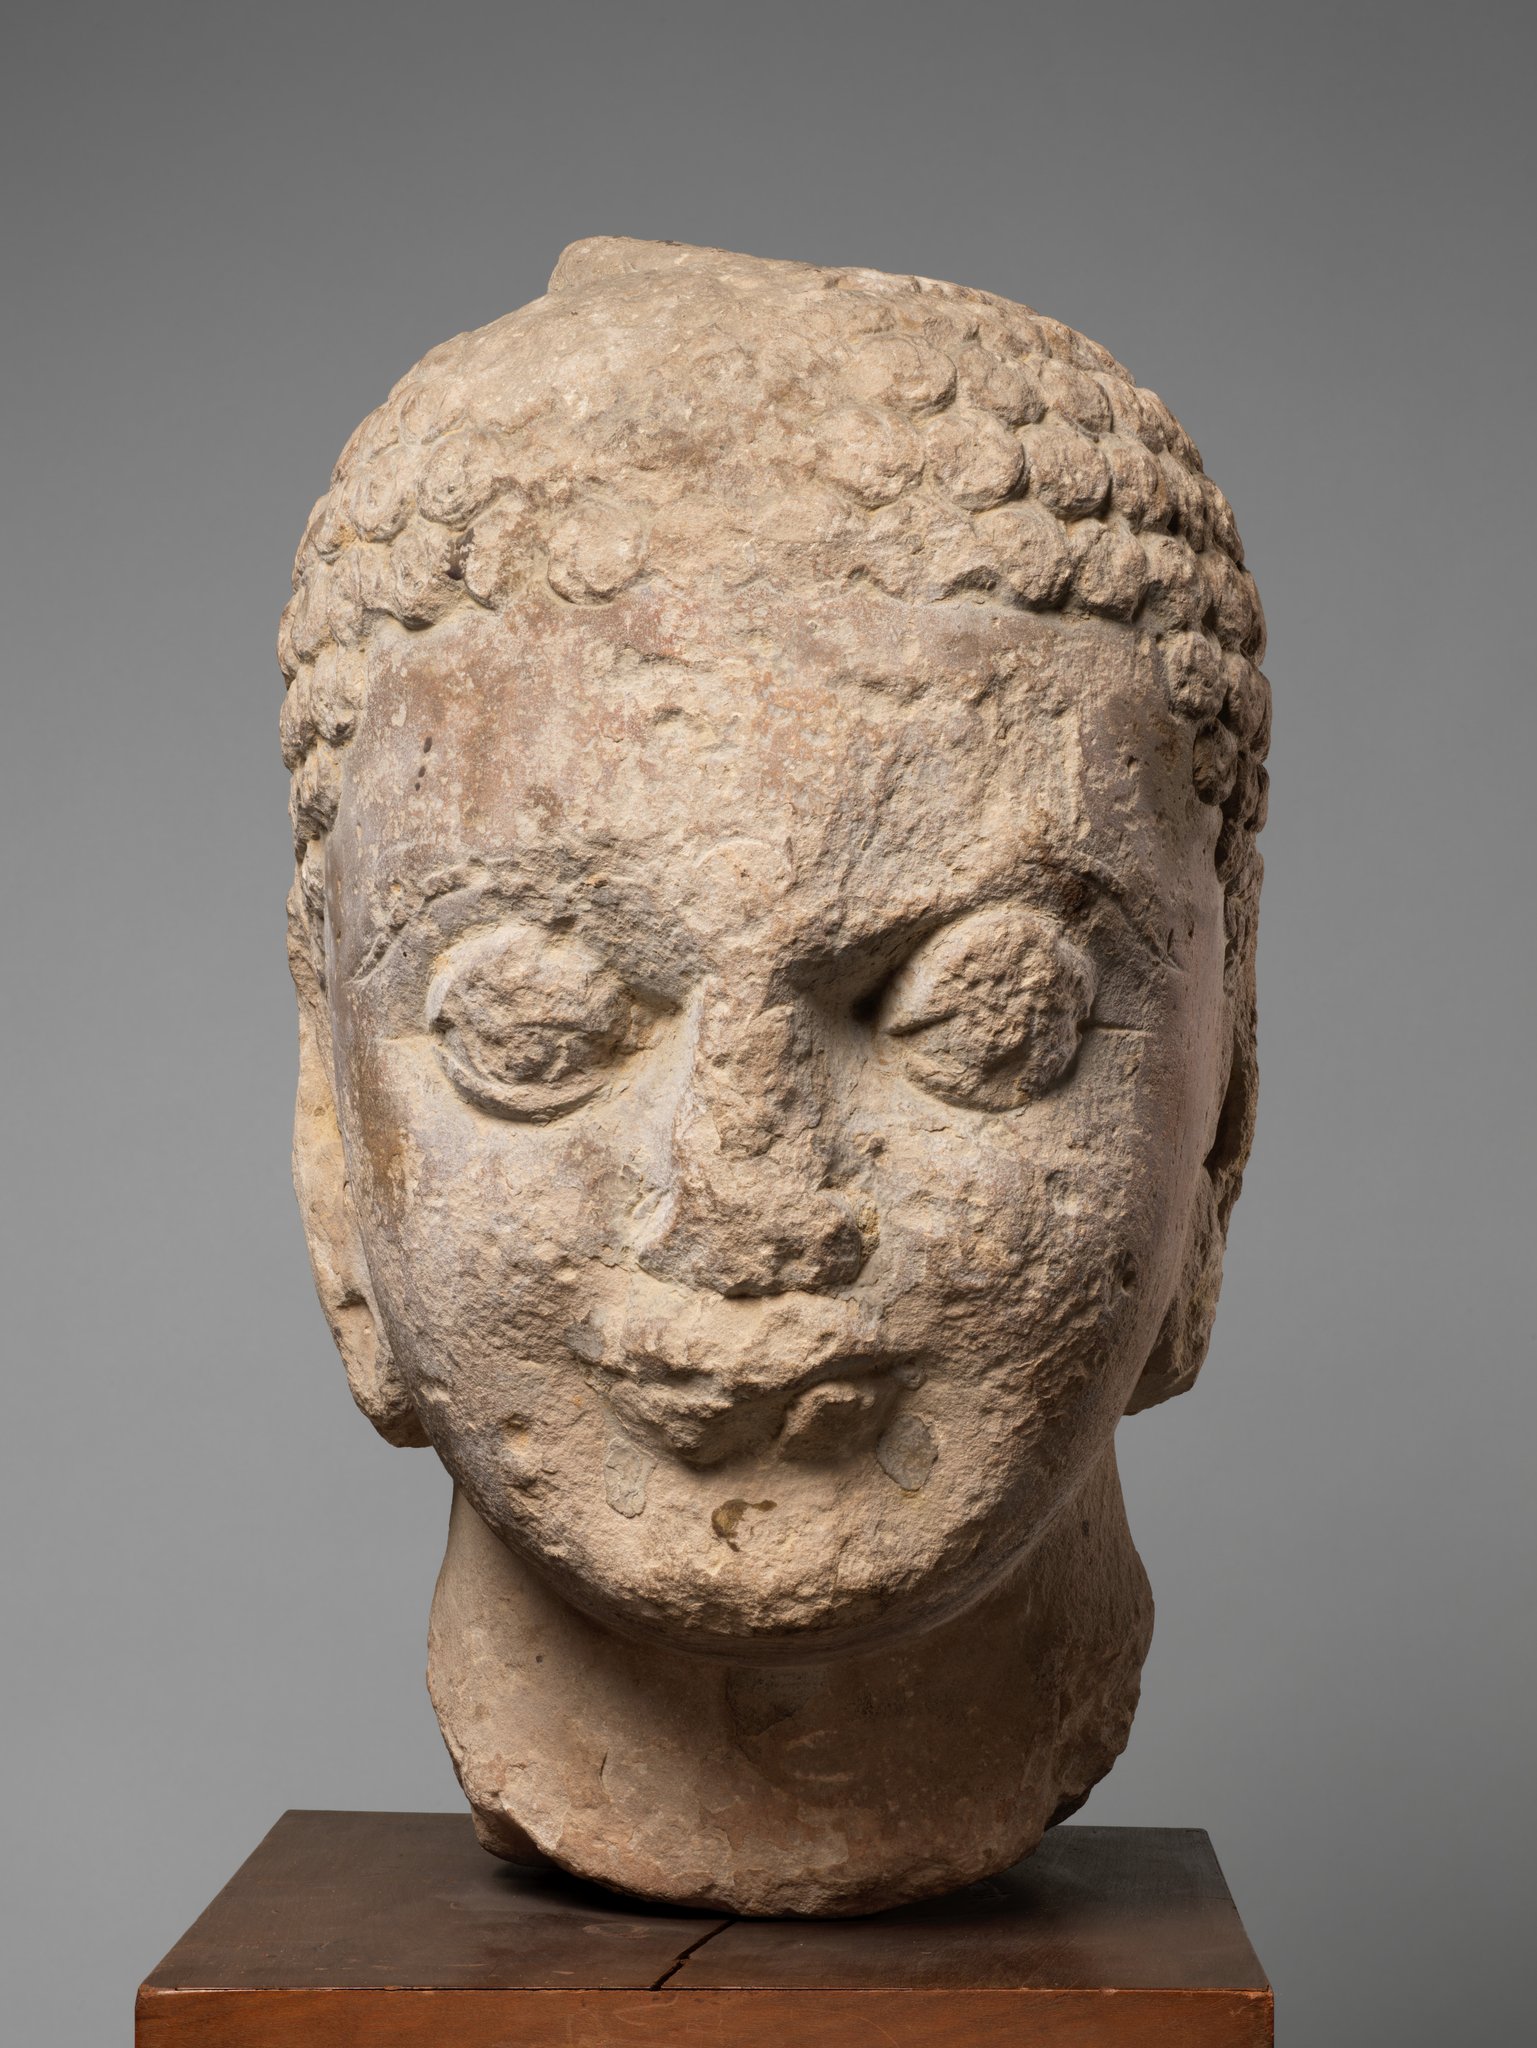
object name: head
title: Head of Buddha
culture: indian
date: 1-200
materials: stone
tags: kushan,mathura,heads,buddhism,buddha